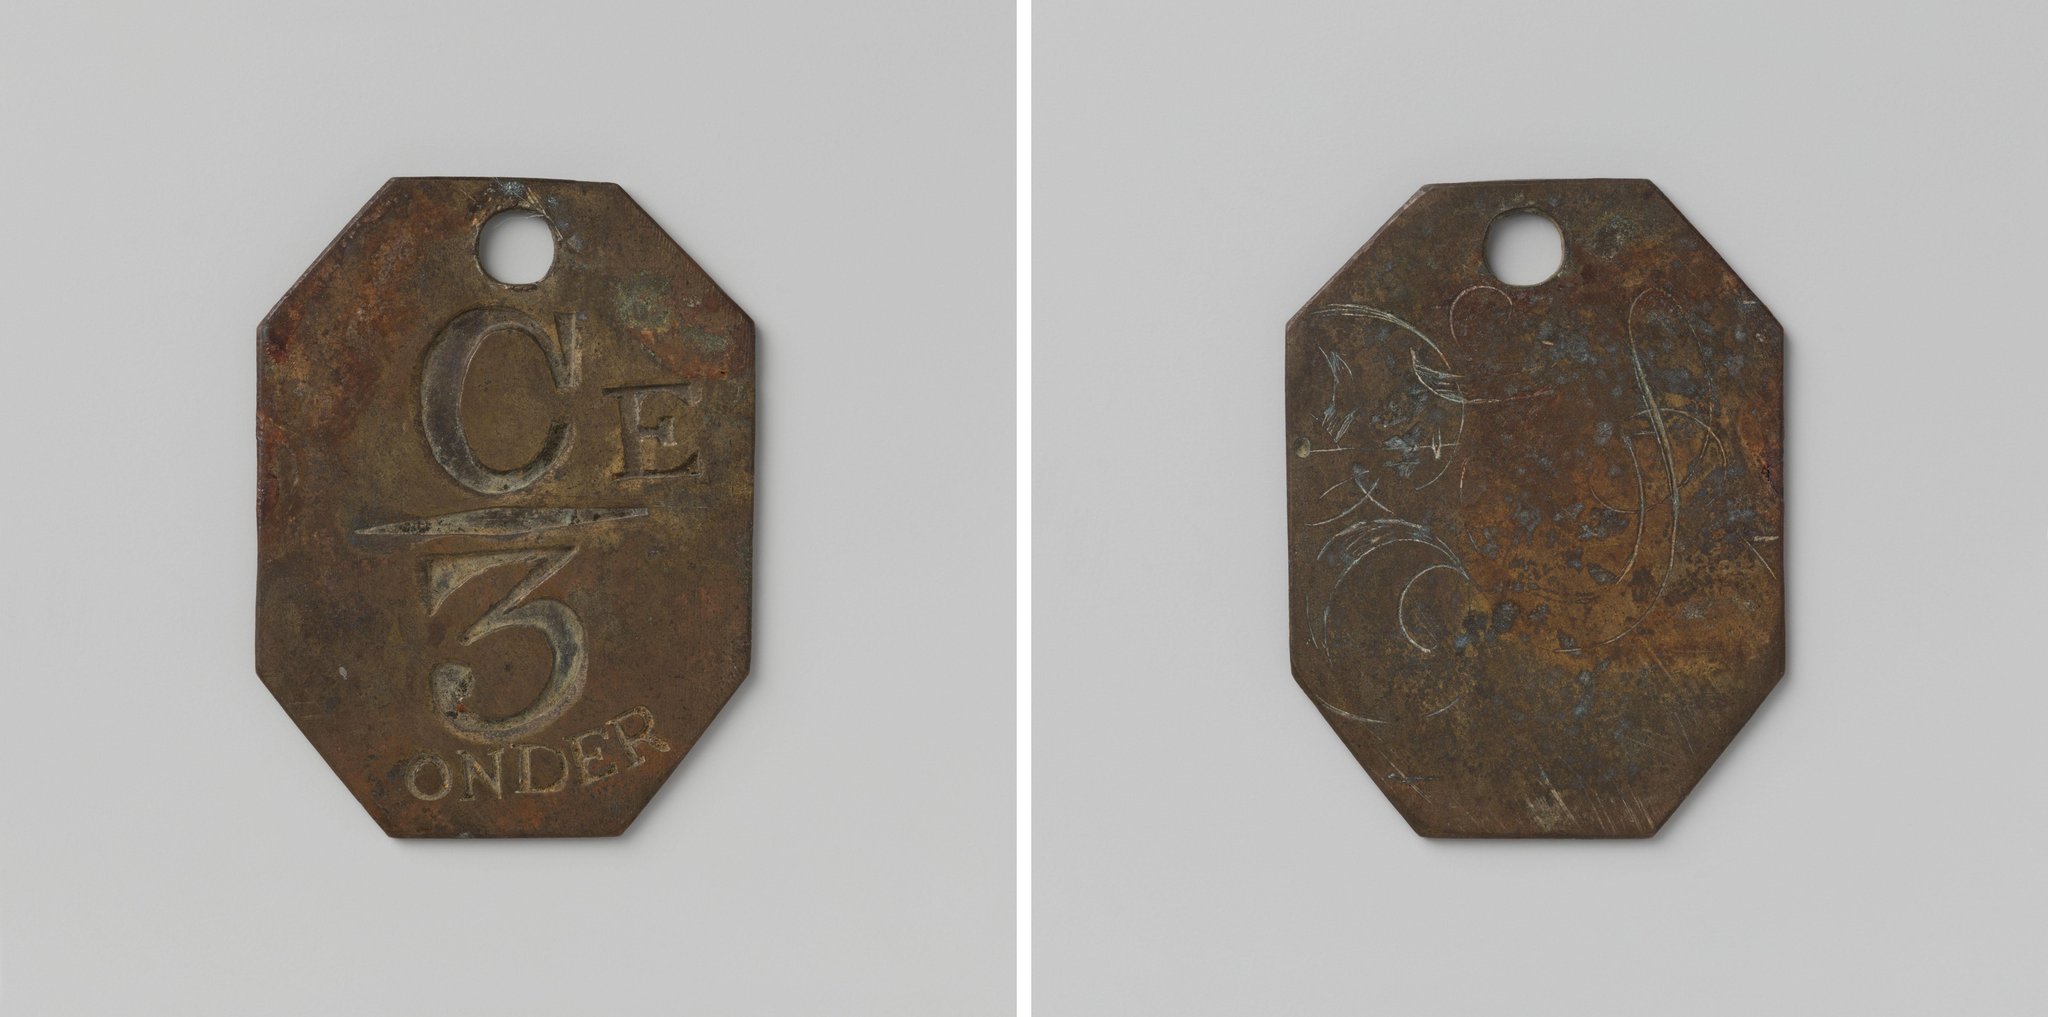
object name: plate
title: Plaat met opschrift Ce 3 onder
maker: Anonymous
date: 1650-1850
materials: copper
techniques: engraving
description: achthoekige penning met gat erin. Voorzijde: opschrift Ce boven cijfer 3 en opschrift "onder". Keerzijde: onduidelijke gravure